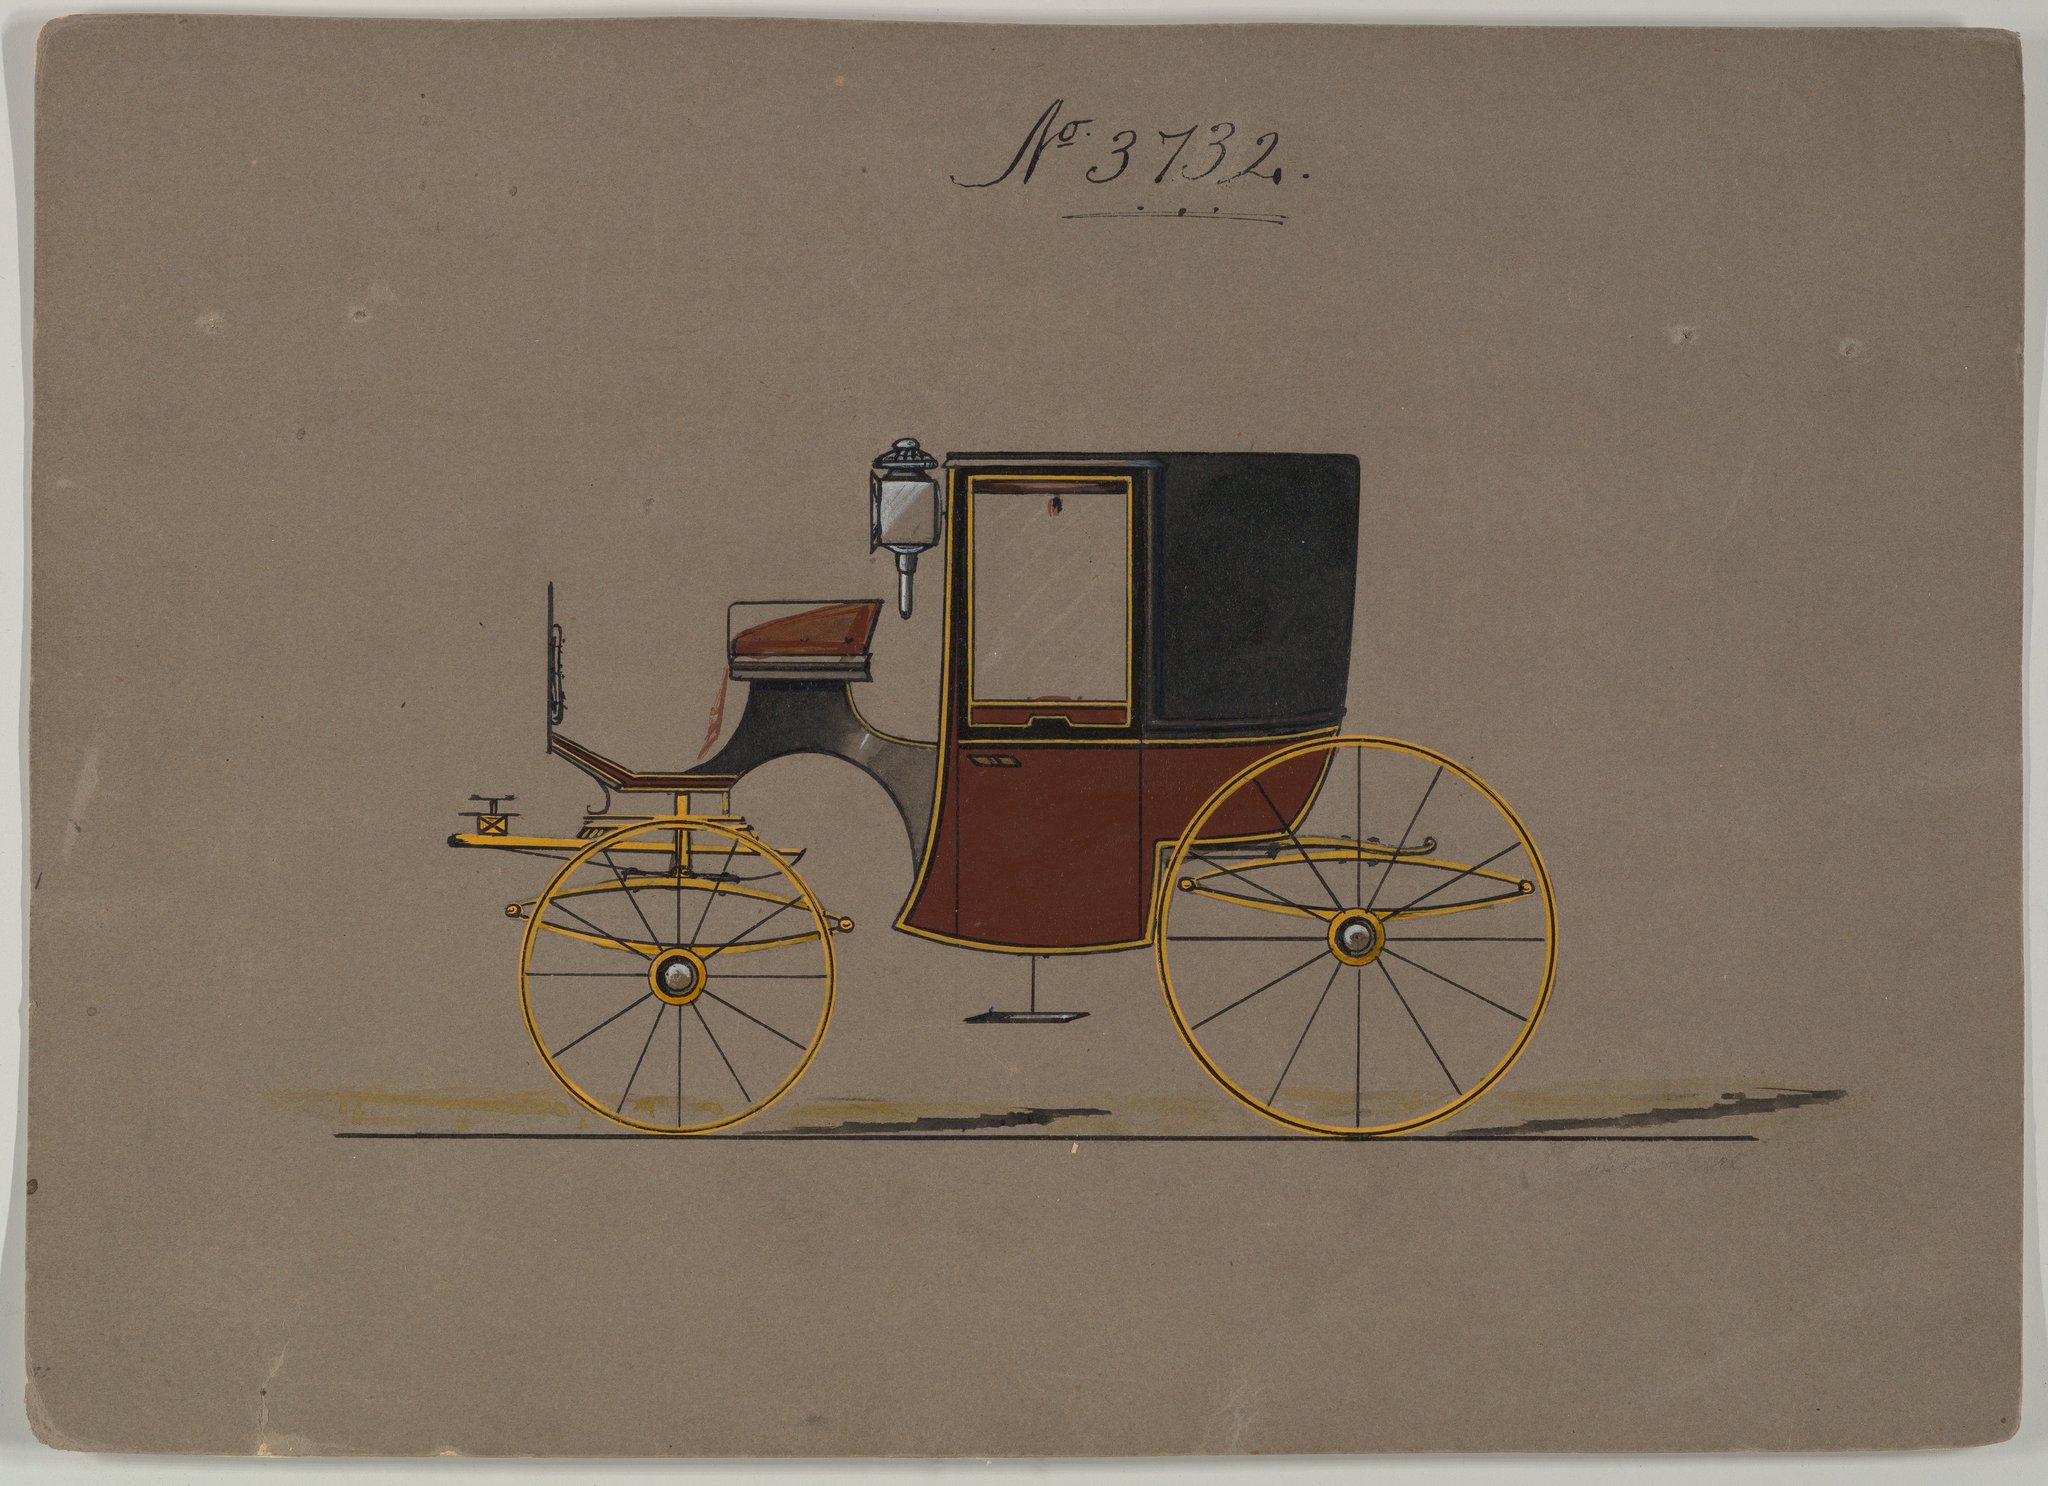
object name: drawing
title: Brougham #3732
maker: brewster & co.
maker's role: manufacturer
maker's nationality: american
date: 1882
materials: gouache, gum arabic, ink, watercolor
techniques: pen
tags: carriages